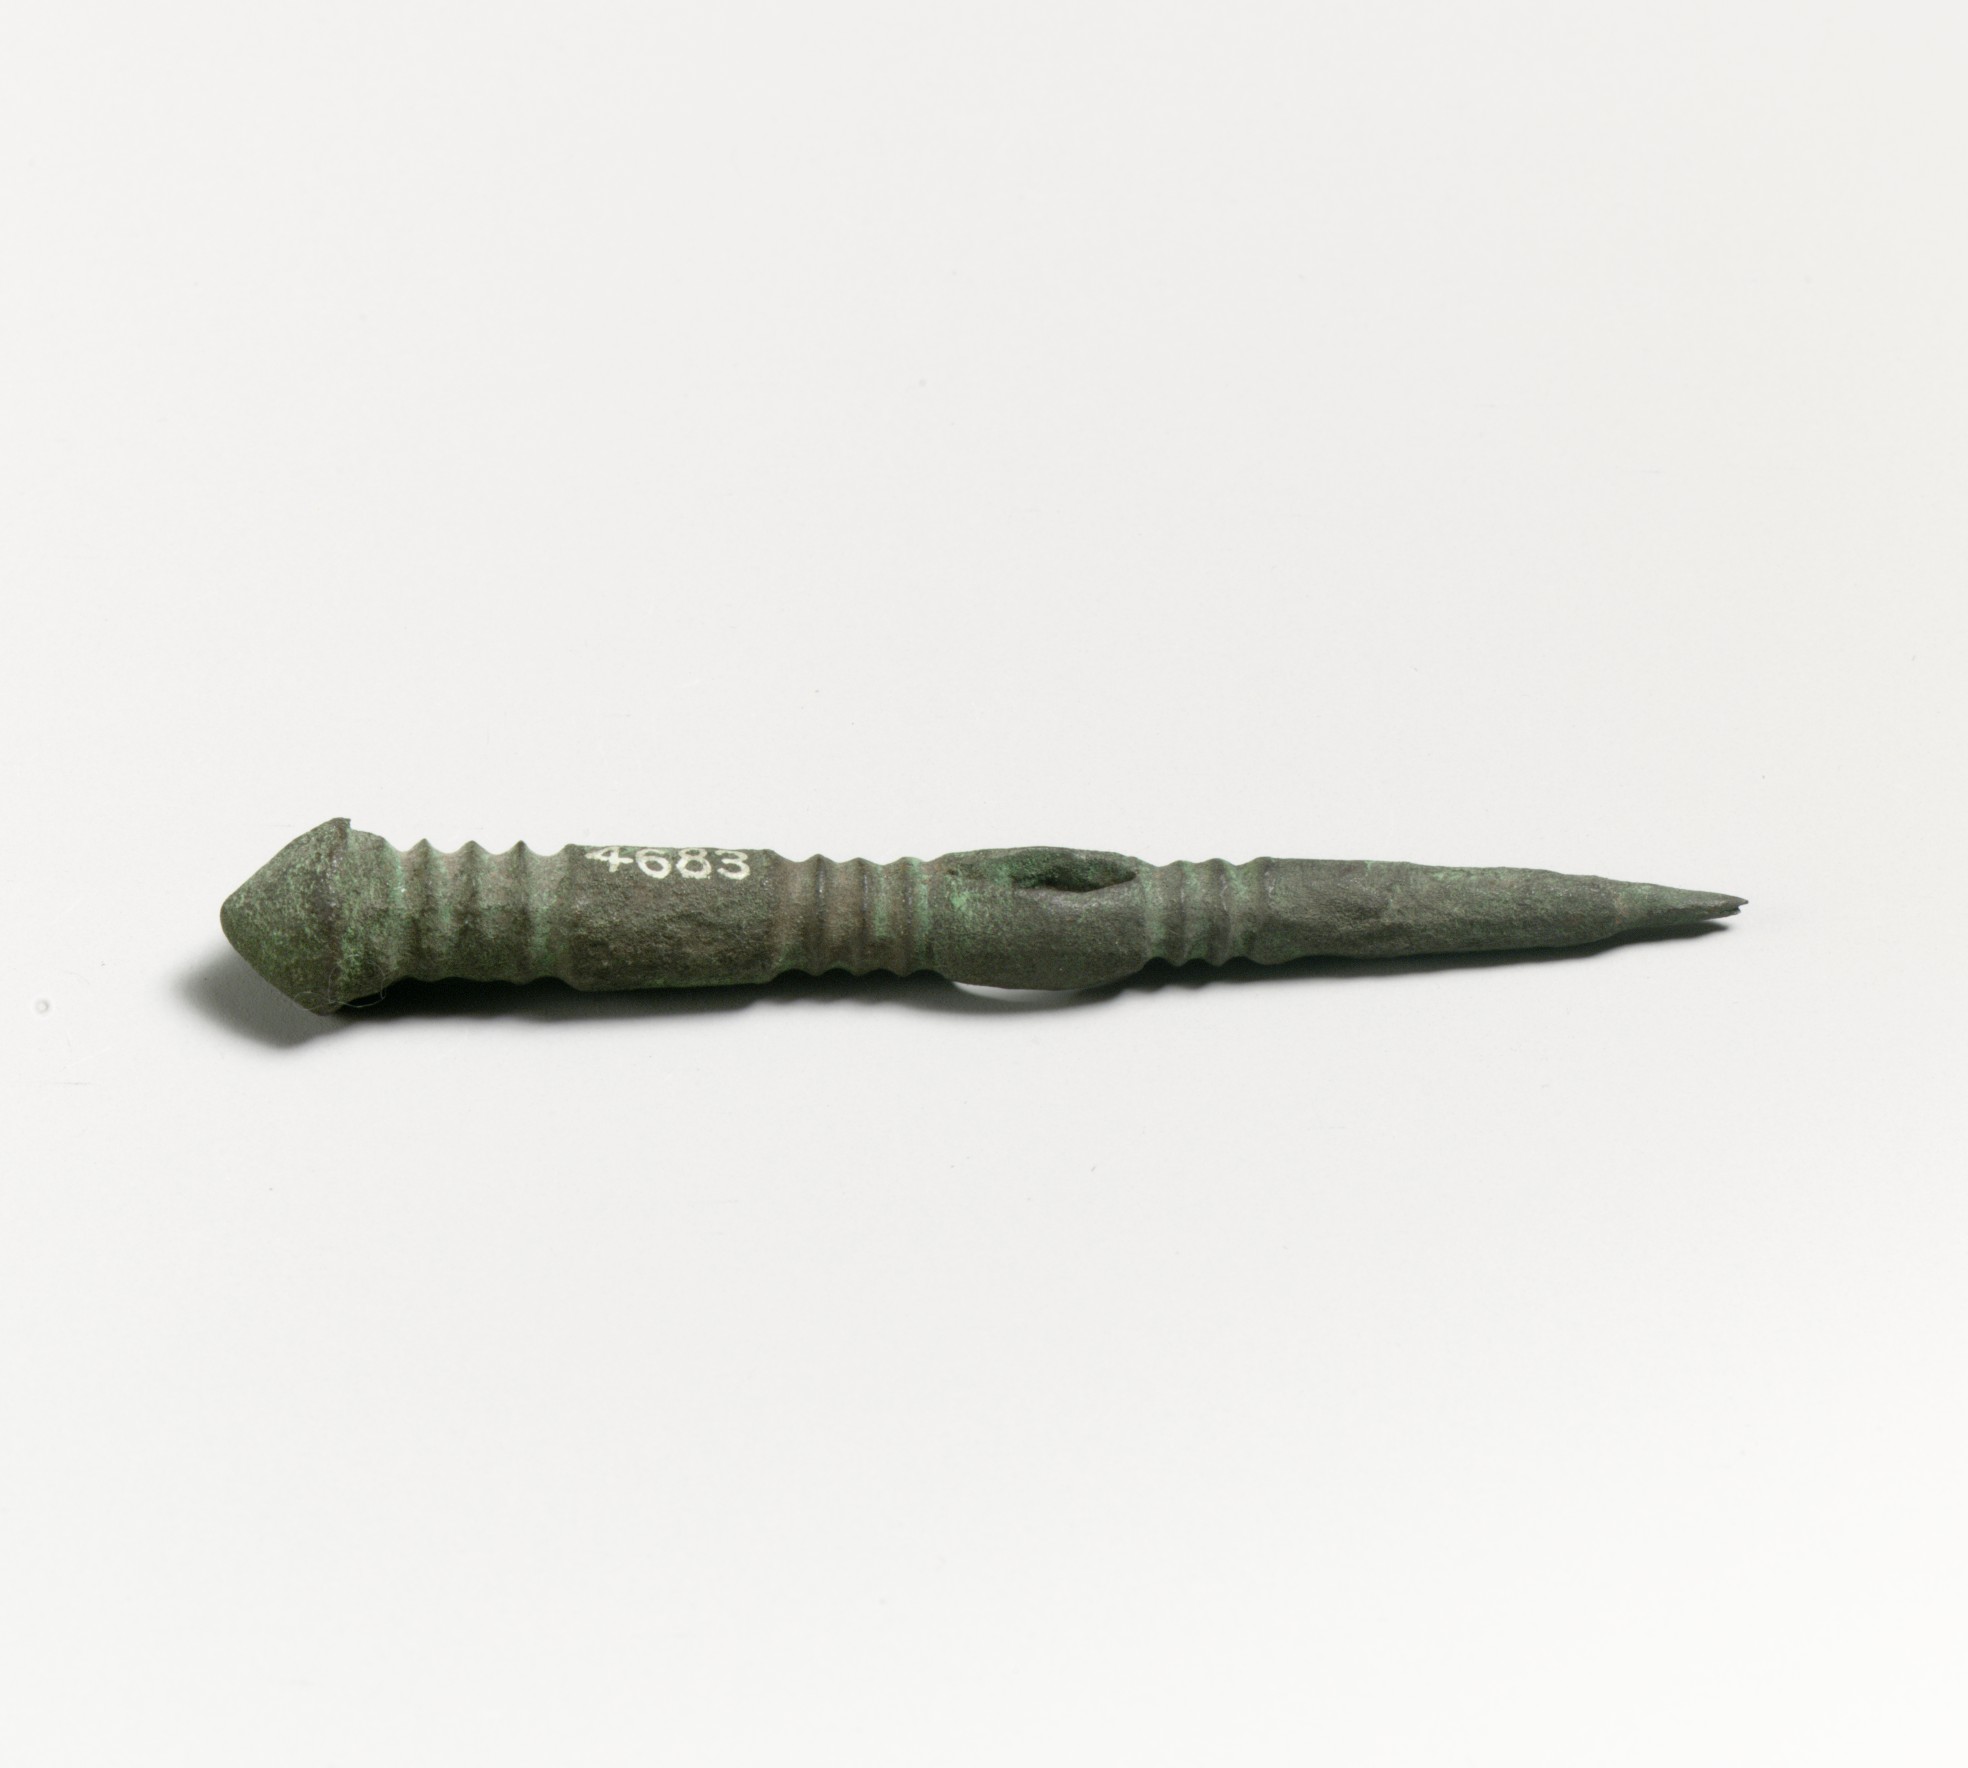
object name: pin, eyelet type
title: Bronze eyelet-type pin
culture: mycenaean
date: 1400-1301 BCE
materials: bronze